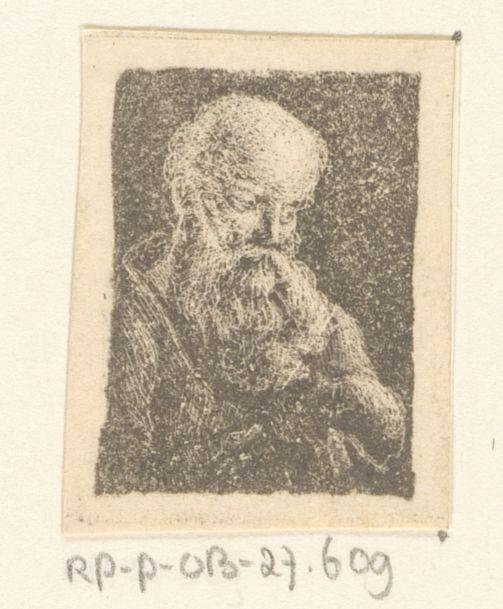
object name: print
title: Oude man met schedel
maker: pieter bartholomeusz. barbiers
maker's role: draughtsman, print maker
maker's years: 1772-1837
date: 1809-1837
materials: paper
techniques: lithograph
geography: haarlem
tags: (human) skull, old man, specific aspects ~ st. jerome - male saint as patron, protector, intercessor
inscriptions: collector's mark: Lugt 2228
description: De man heeft een baard en een kaal hoofd. Hij kijkt naar rechtsonder. In zijn linkerhand heeft hij een schedel. Mogelijk de heilige Hieronymus.